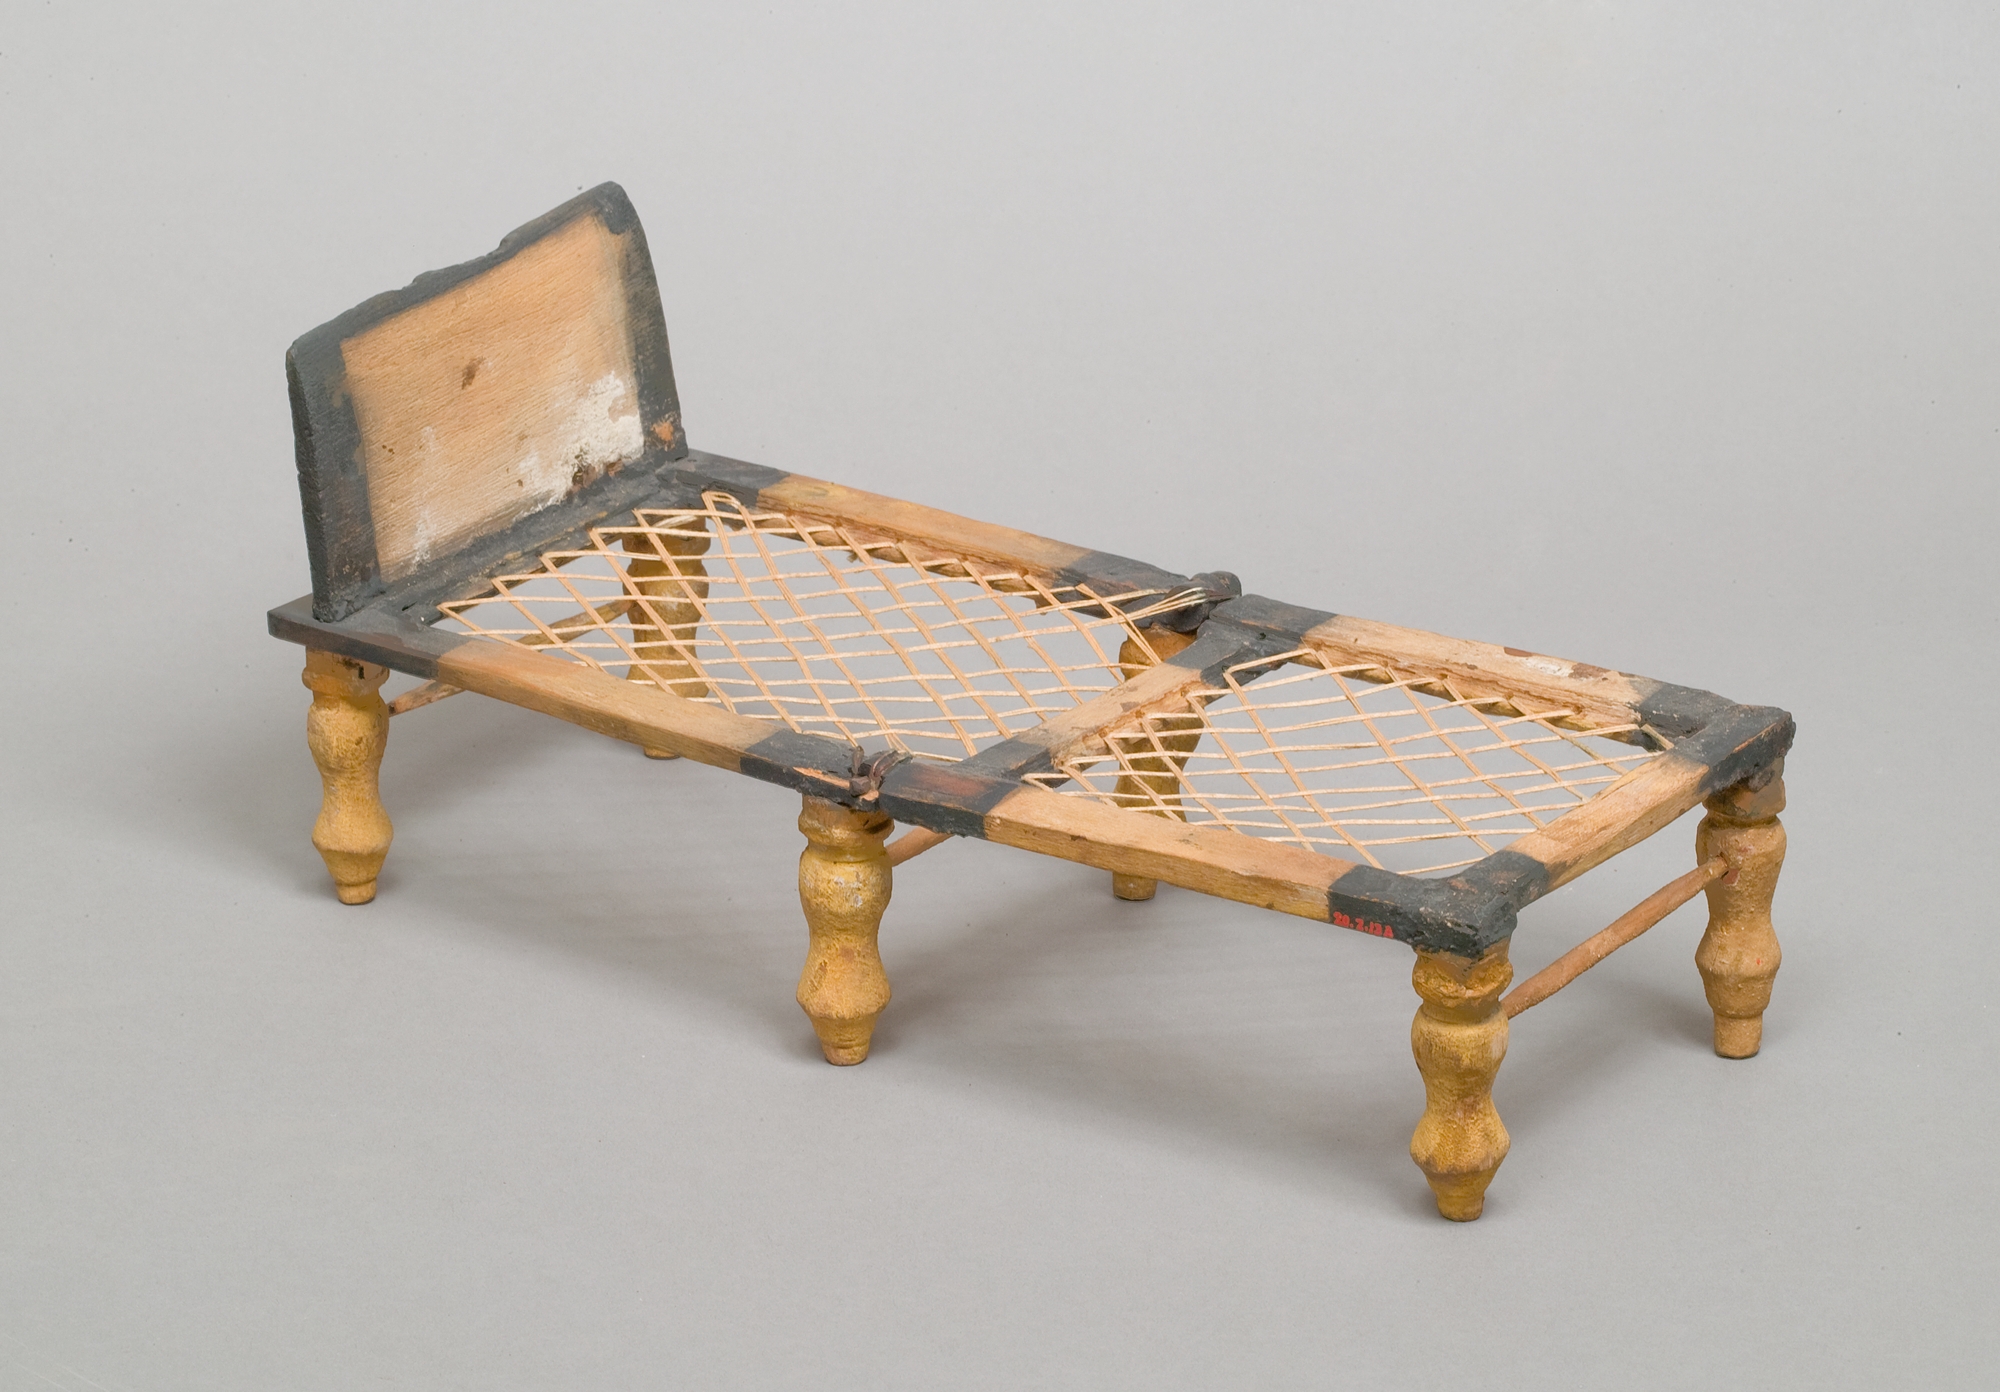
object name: model folding bed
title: Model of a Folding Bed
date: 1550-1295 BCE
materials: cord, wood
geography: egypt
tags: beds